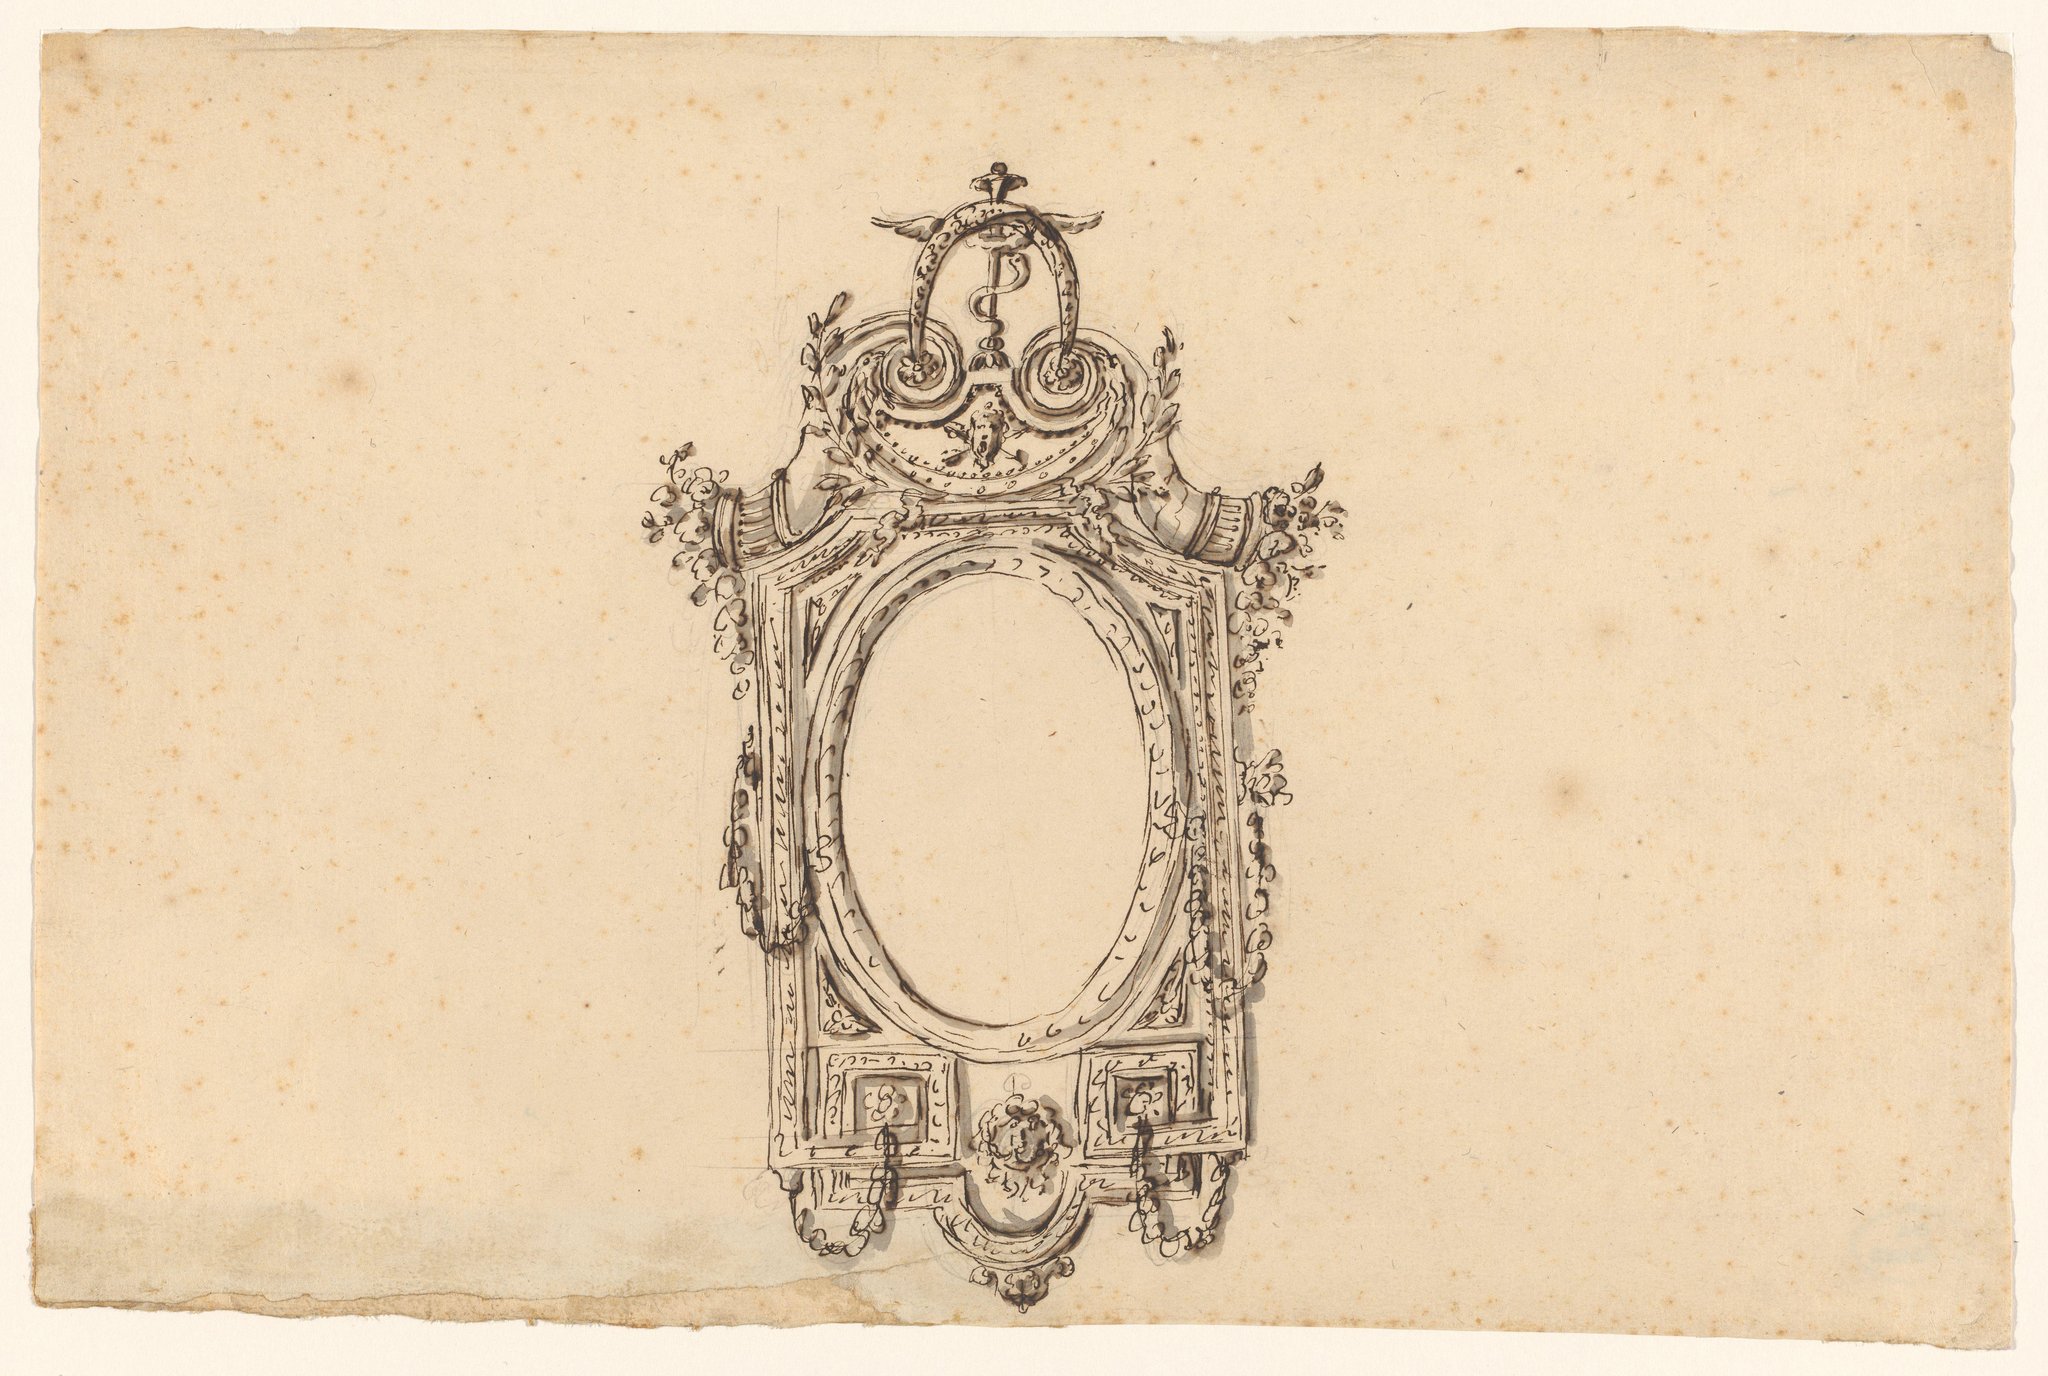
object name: drawing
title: Ontwerp, vermoedelijk voor een wandblaker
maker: Anonymous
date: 1770-1780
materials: ink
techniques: drawing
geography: italy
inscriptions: inscription: ‘ovaal verzamelaarsmerk Col. L. BONGARD’, watermark: ‘GC’